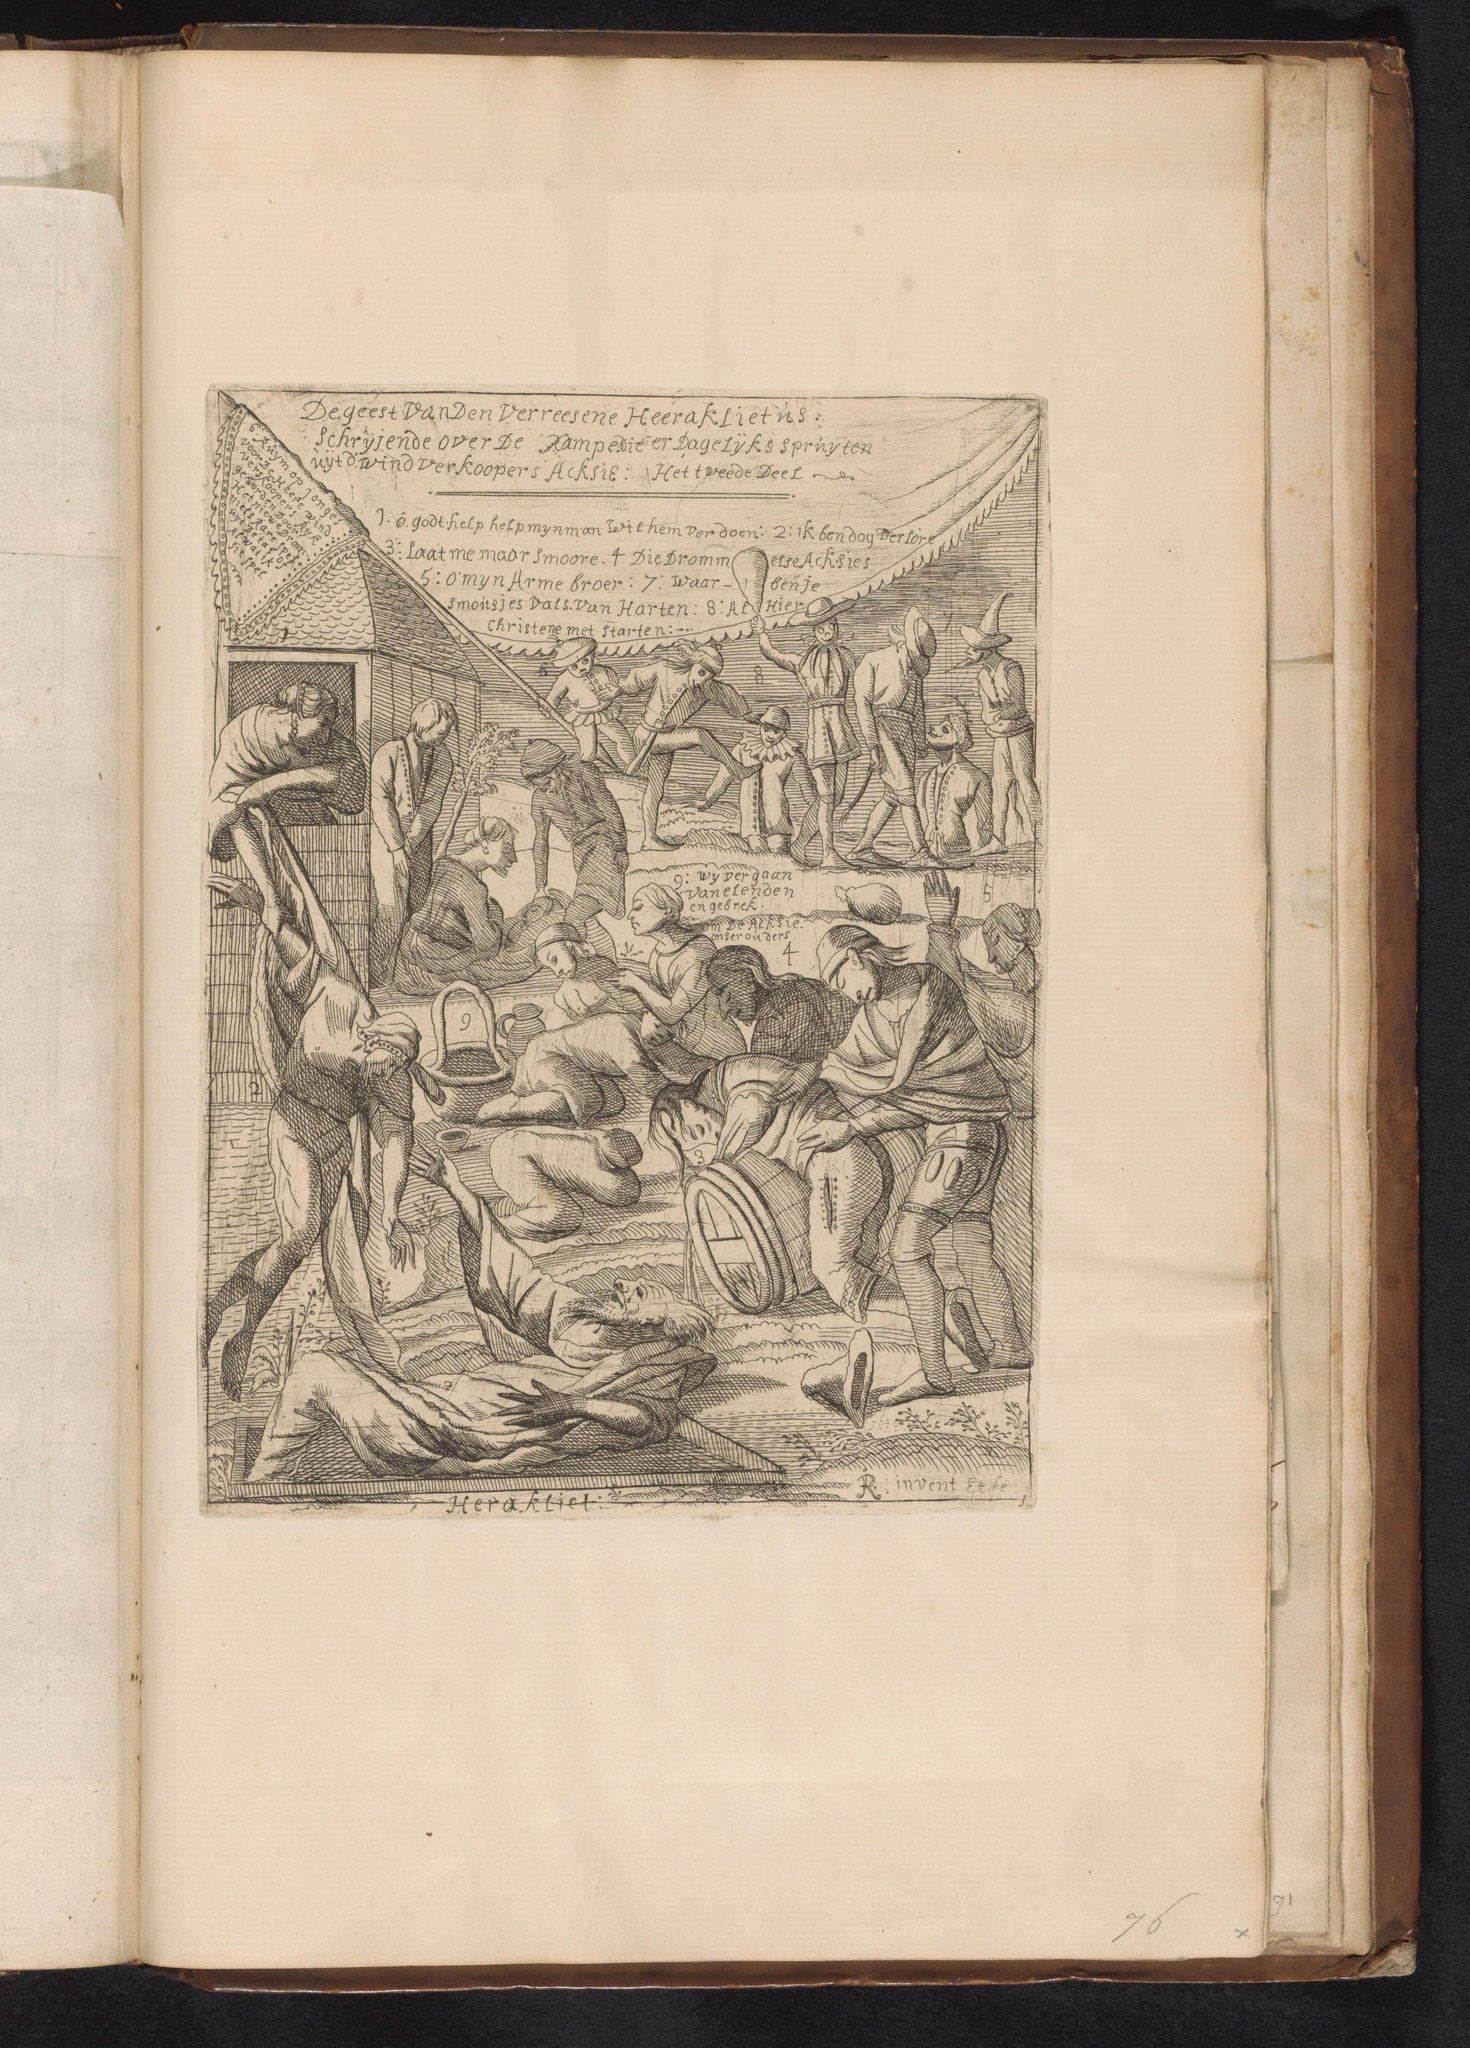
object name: print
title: Rampzalige gevolgen van de actiehandel, 1720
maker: jan de ridder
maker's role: print maker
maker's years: 1665-1735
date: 1720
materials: paper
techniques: etching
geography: northern netherlands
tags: non-aggressive activities of heraclitus, suicide out of despair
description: De rampzalige gevolgen van de actiehandel. Armoede en wanhoop onder de families die alles hebben verloren in de actiehandel. Op de voorgrond de treurende Heraclitus. Bovenaan de verklaring van de cijfers 1-9. Prent uitgeknipt en ingeplakt. Behoort tot de groep van bijprenten meegebonden in de gebonden eerste uitgave (304 B 11) van Het Tafereel der Dwaasheid met spotprenten op de Windhandel of Actiehandel van 1720.